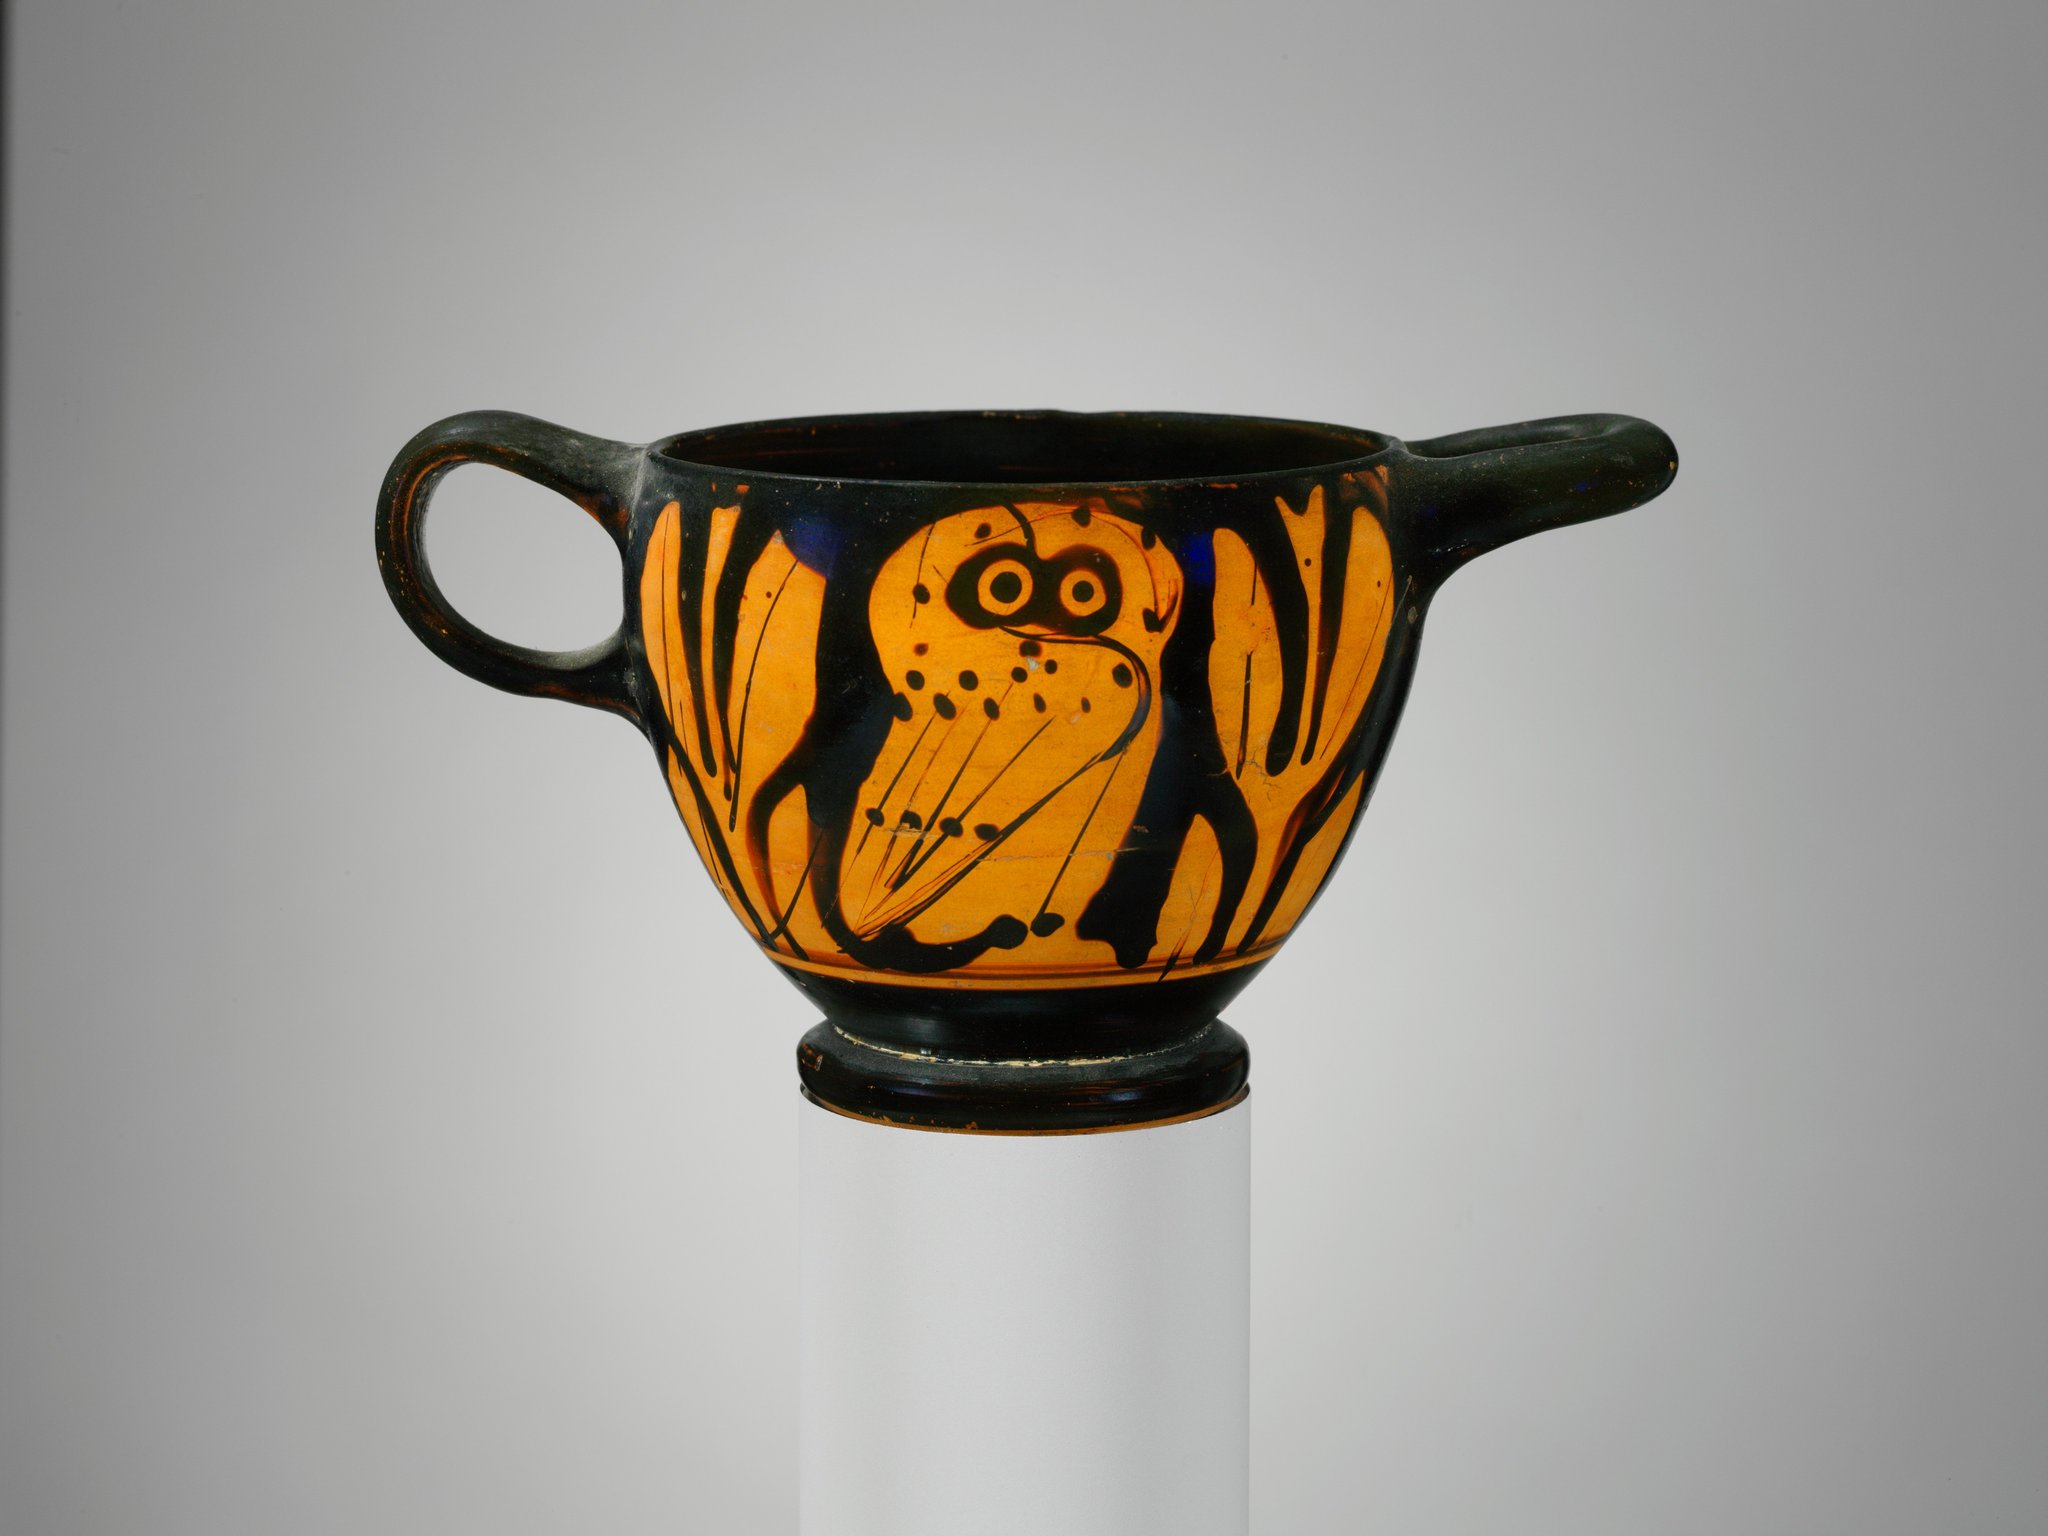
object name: skyphos, glaux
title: Terracotta skyphos (deep drinking cup)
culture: greek, attic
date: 467-435 BCE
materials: terracotta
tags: owls